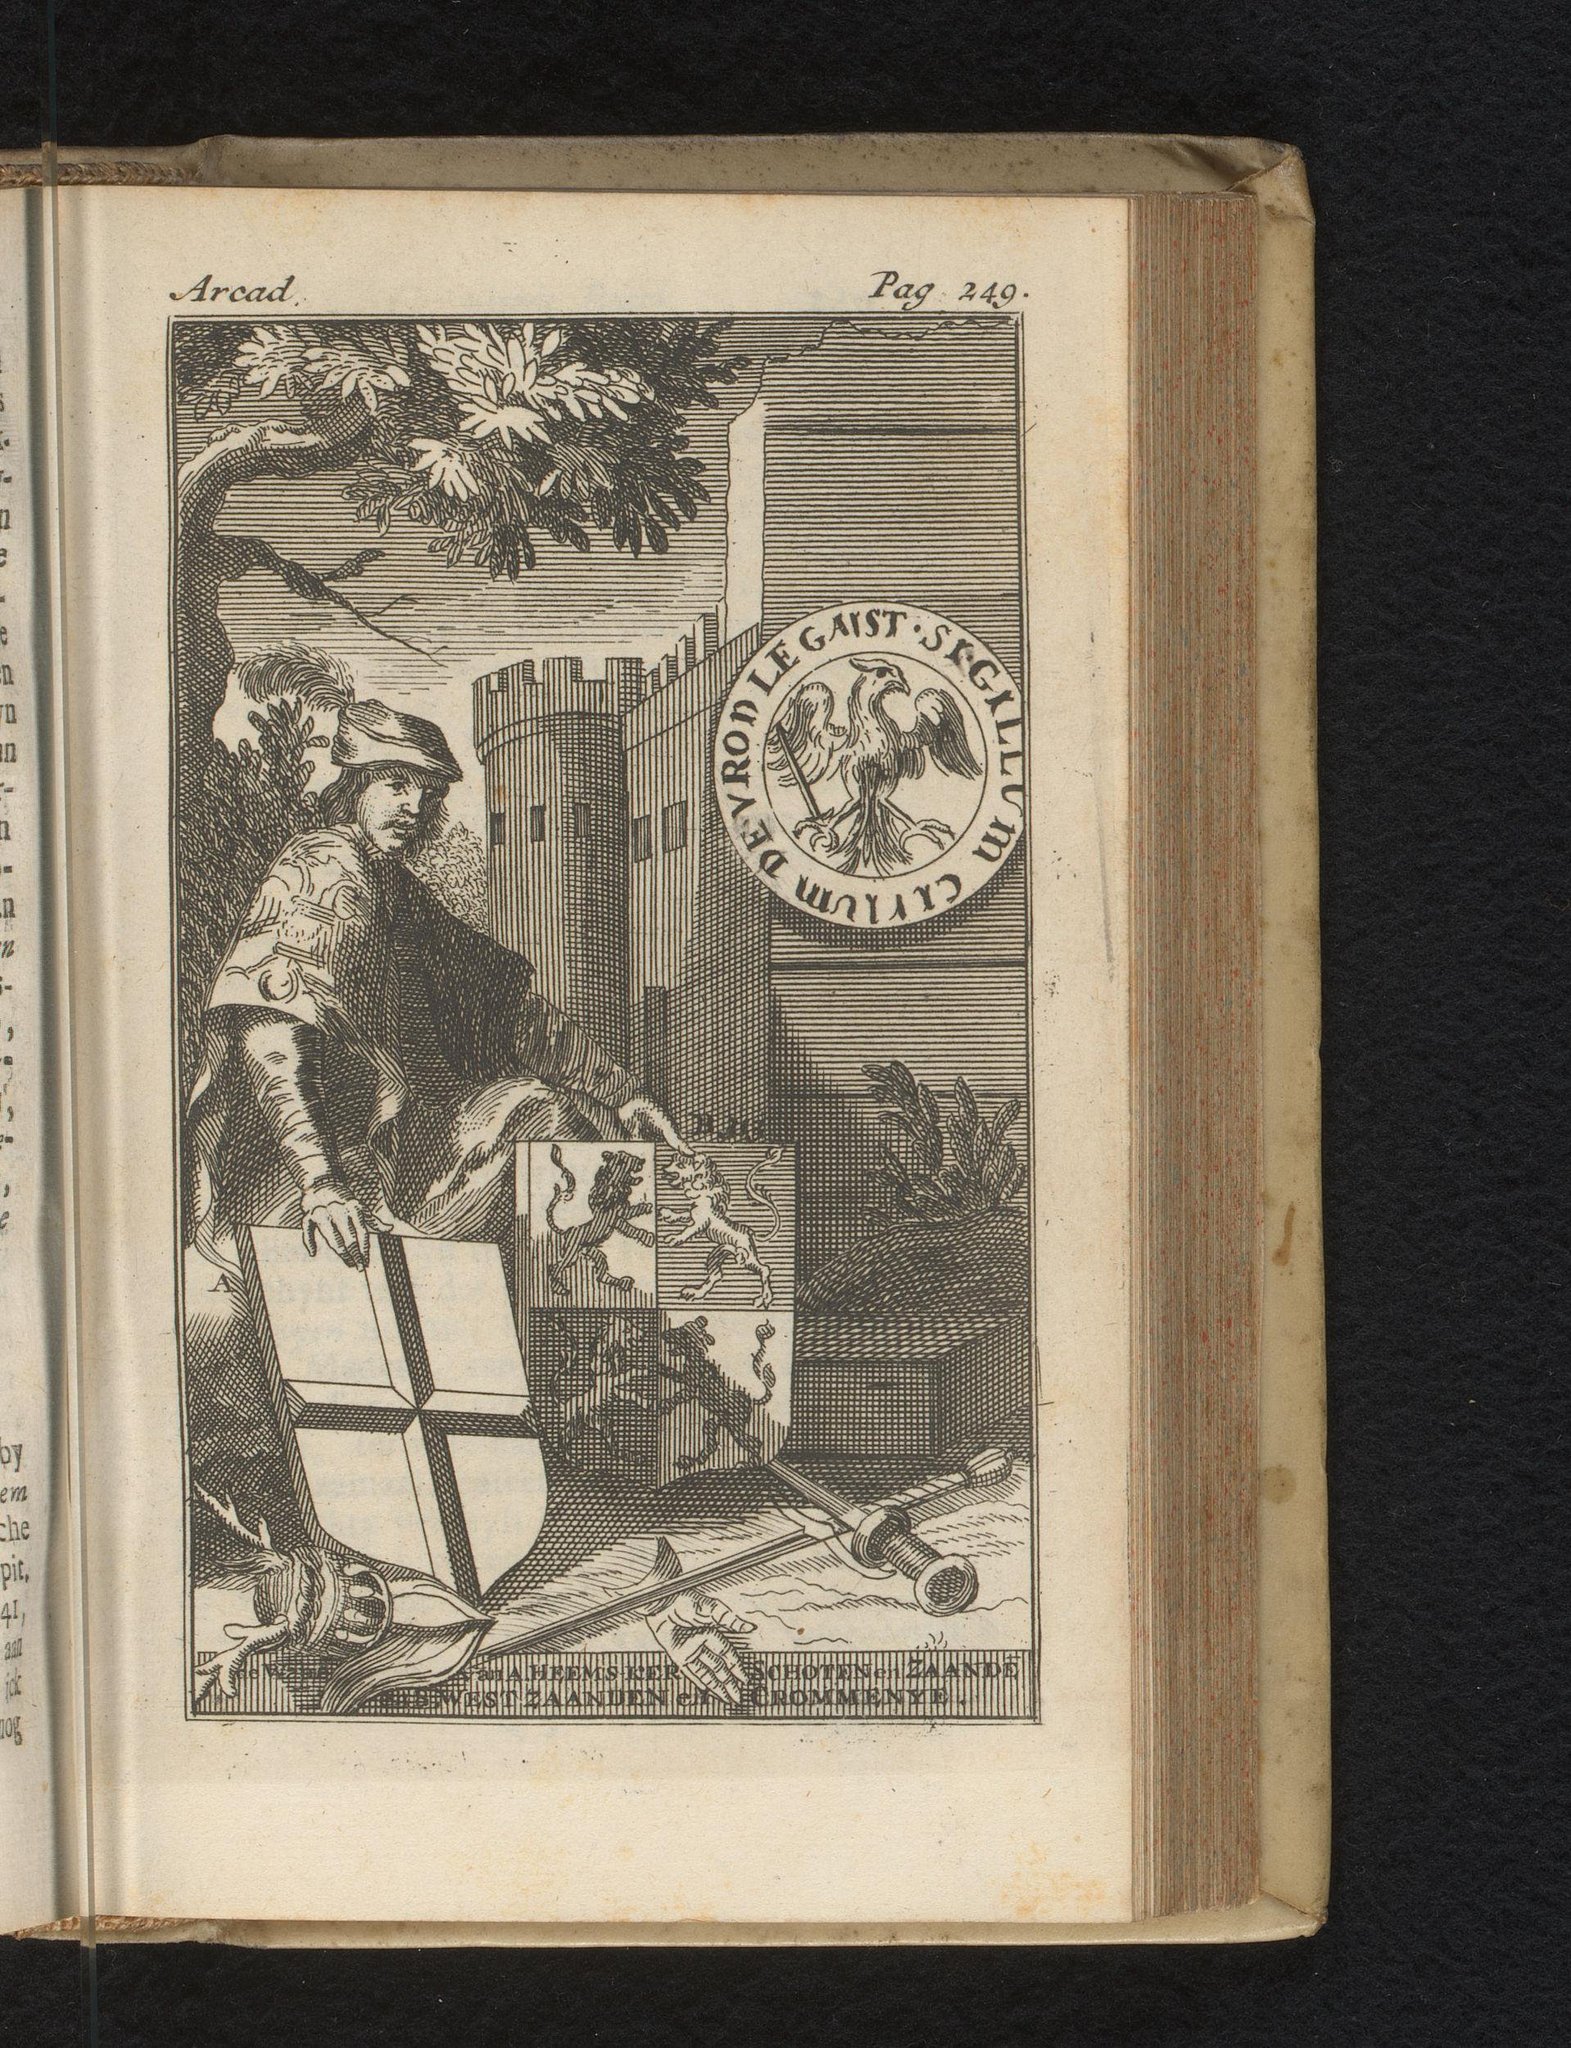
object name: history print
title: De wapens van Heems-Kerk, Schoten en Zaande[n], West-Zaanden en Krommenye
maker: pieter van den berge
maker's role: draughtsman, print maker, printer, publisher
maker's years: 1659-1737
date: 1700-1702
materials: paper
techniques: etching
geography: northern netherlands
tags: westzaan, zaanstreek, heemskerk, krommenie, zaandam, schoten, nederland tijdens de late middeleeuwen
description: Illustratie in: H. Soeteboom, Oud-heden van Zaan-land, Stavoren, Vronen en Waterland : deze laatste druk ... met nodige aanteekeningen, figuren, en een landkaart verrykt / Saan-Landse Arcadia, W. Linnig van Koppenol, Amsterdam 1702, dl. 1, ingebonden tussen p. 248/249.